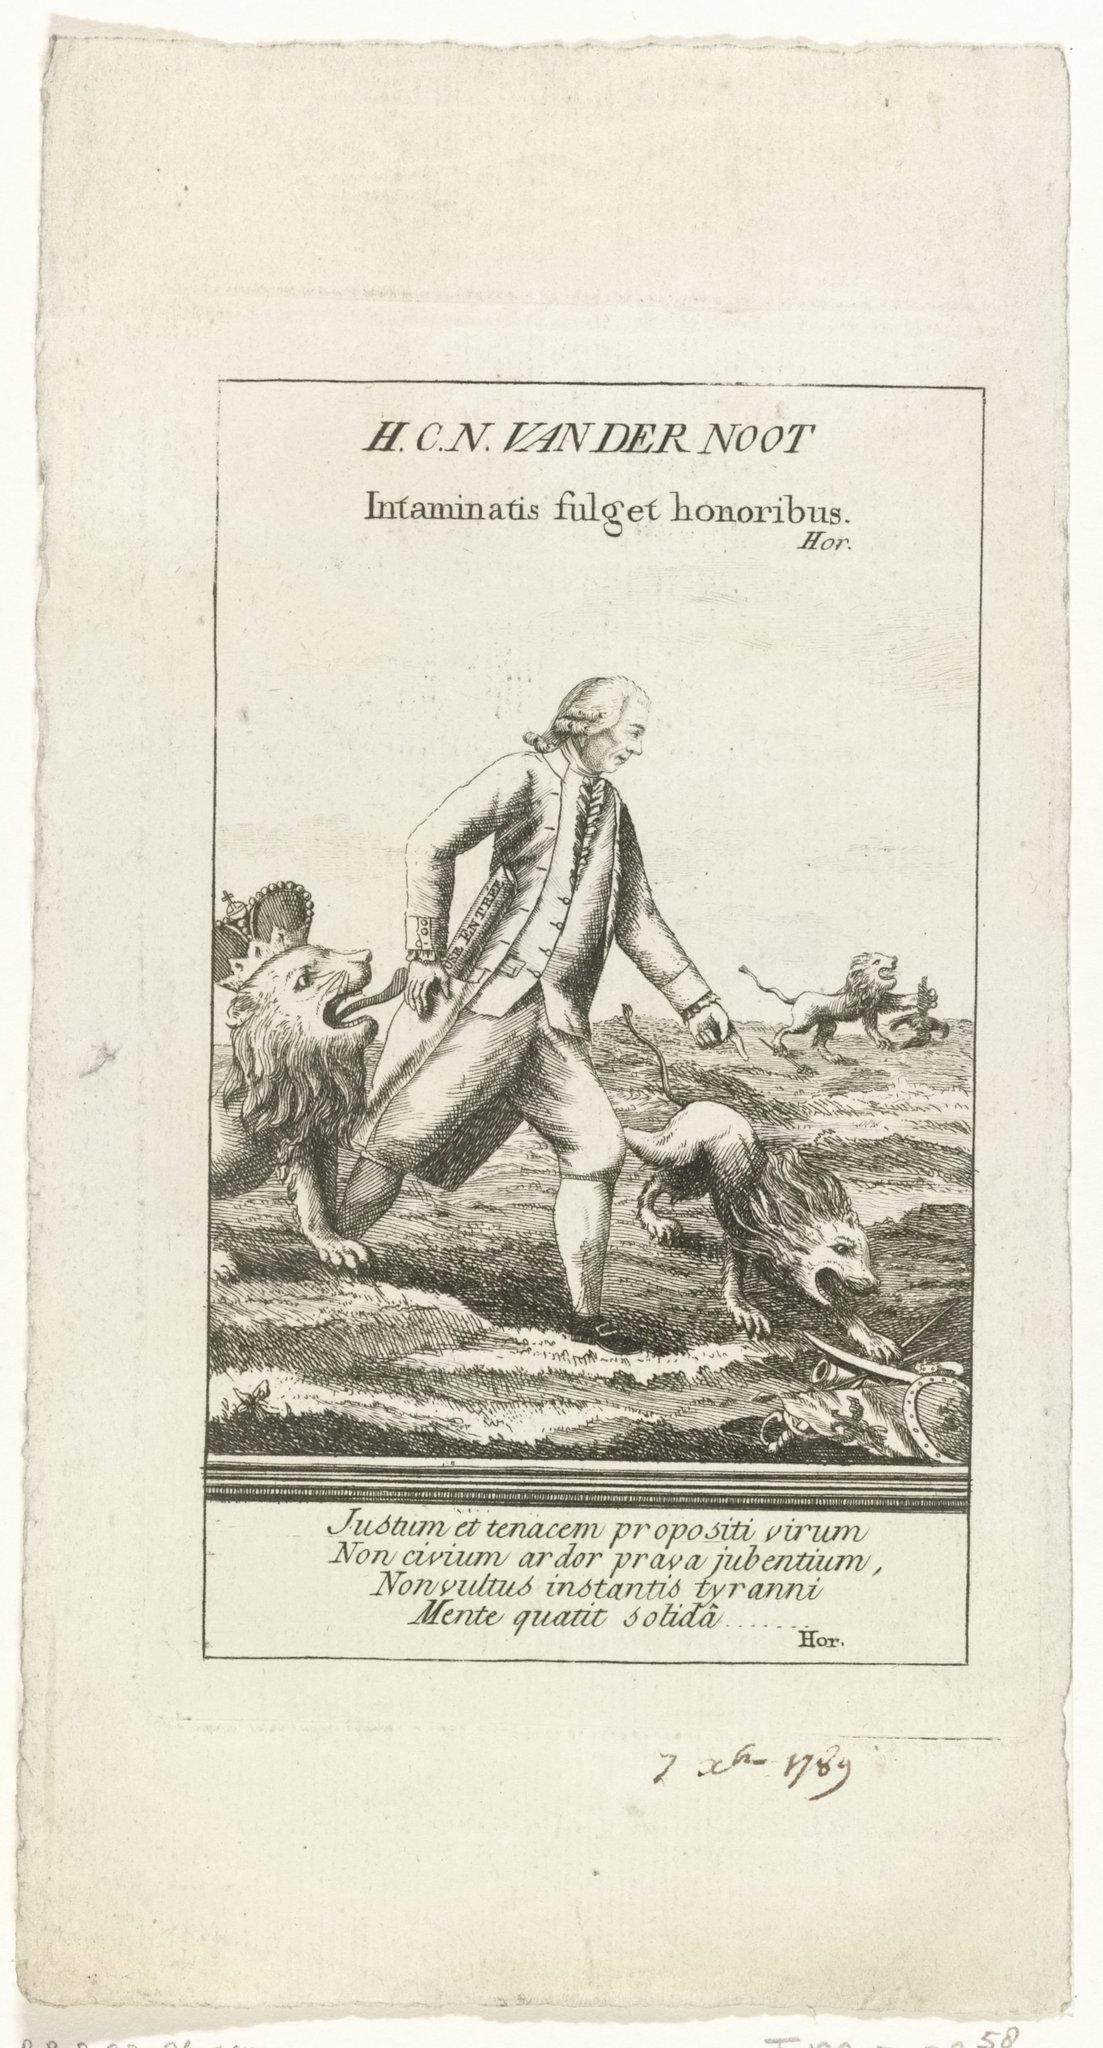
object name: cartoon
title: Spotprent op Hendrik van der Noot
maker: Anonymous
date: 1787-1790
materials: paper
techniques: engraving, etching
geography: southern netherlands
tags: brussels, politician, brabant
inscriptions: collector's mark: Lugt 2228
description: Spotprent waarin Hendrik van der Noot de Brabantse leeuw wijst op de Oostenrijkse wapens die op de grond liggen. Links likt (?) een keizerlijke leeuw de hand van Van der Noot. Op de achtergrond vangt de Brabantse leeuw een Oostenrijkse adelaar. Hierbij de datum 7 oktober 1789 met de hand geschreven. Onderdeel van een grote groep van prenten betrekking hebbend op de gebeurtenissen van de Brabantse Omwenteling en de periode 1787-1790.